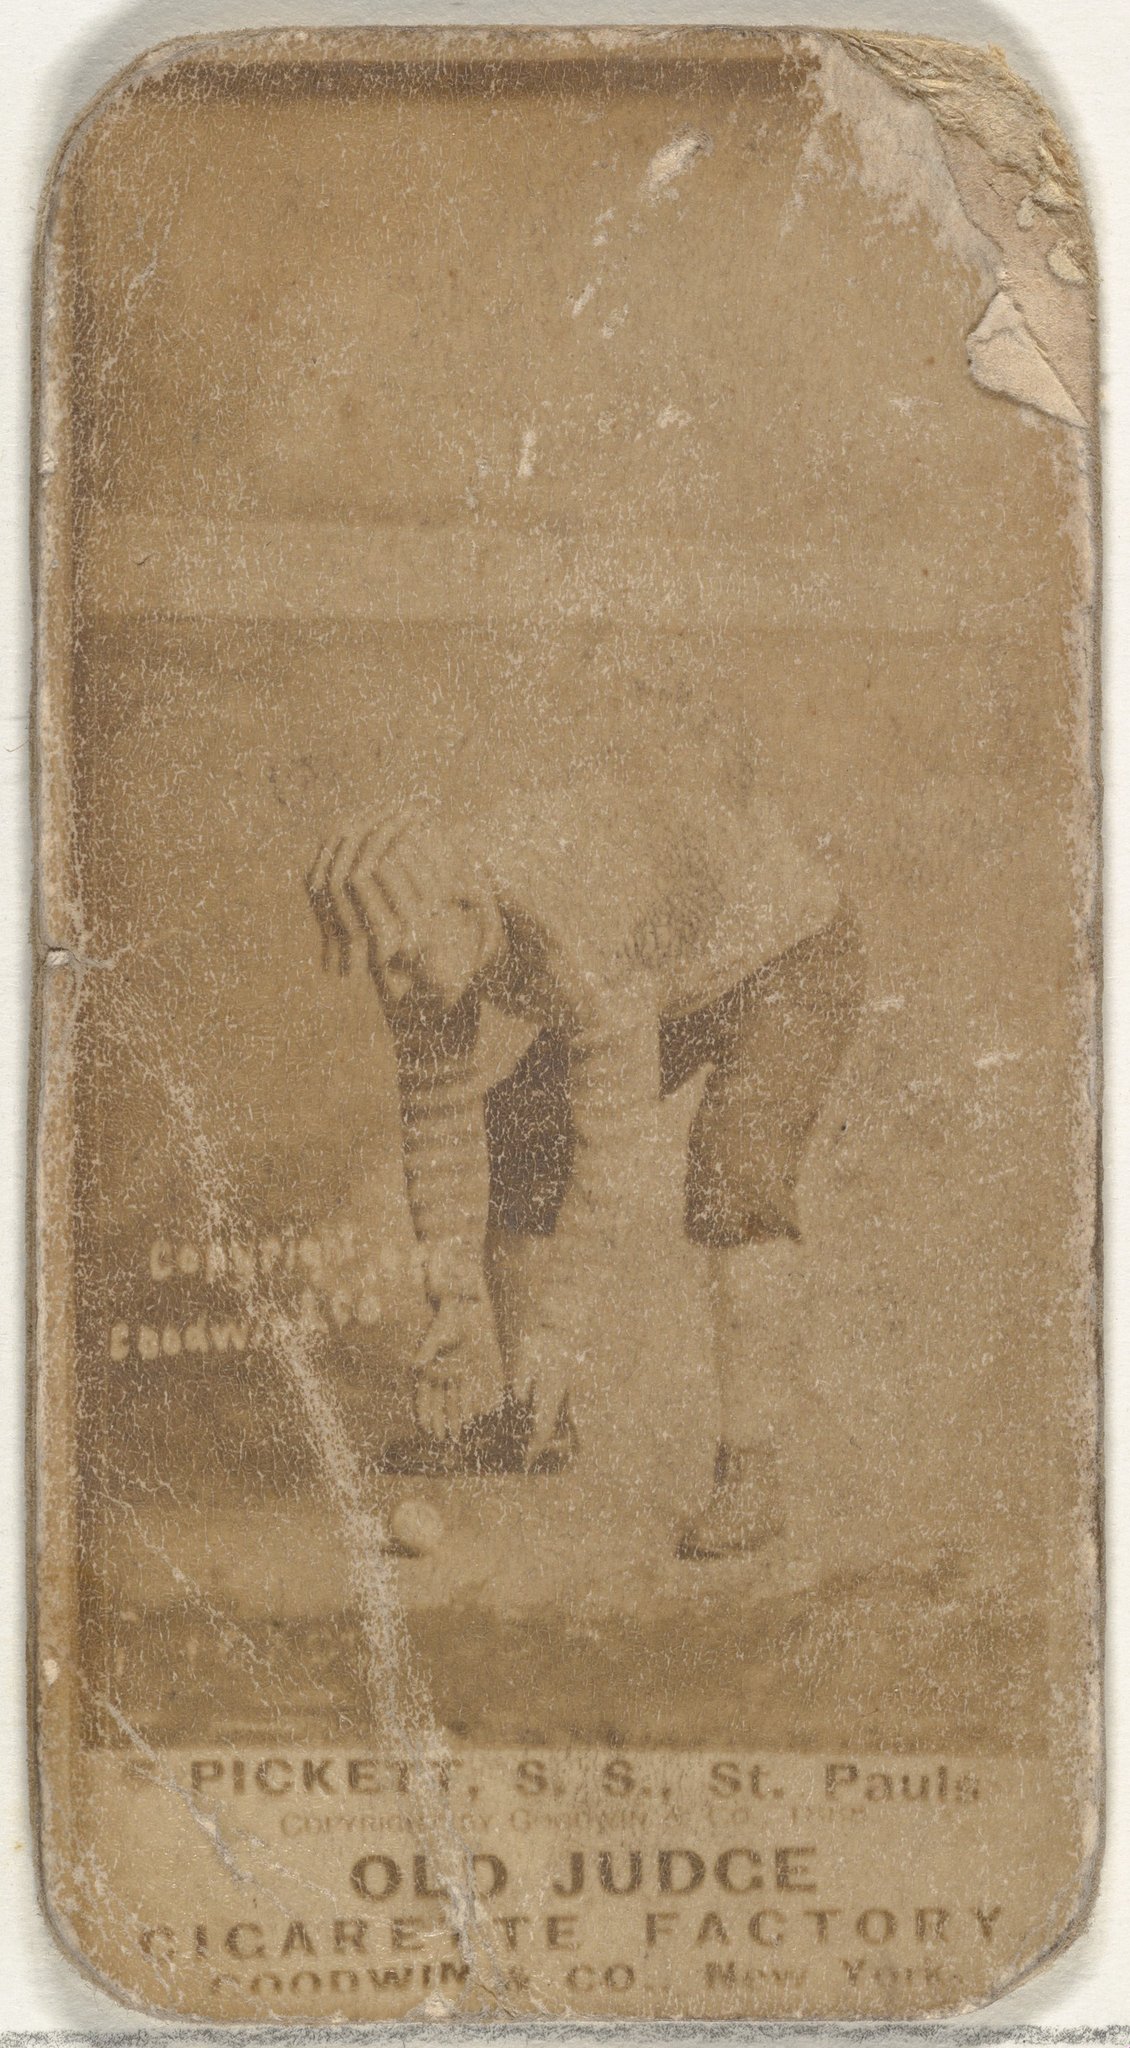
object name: baseball card, photograph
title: John Thomas Pickett, Shortstop, St. Paul Apostles, from the Old Judge series (N172) for Old Judge Cigarettes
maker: goodwin & company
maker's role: publisher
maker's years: 1850-1950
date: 1888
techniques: albumen silver print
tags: men,portraits,baseball,athletes